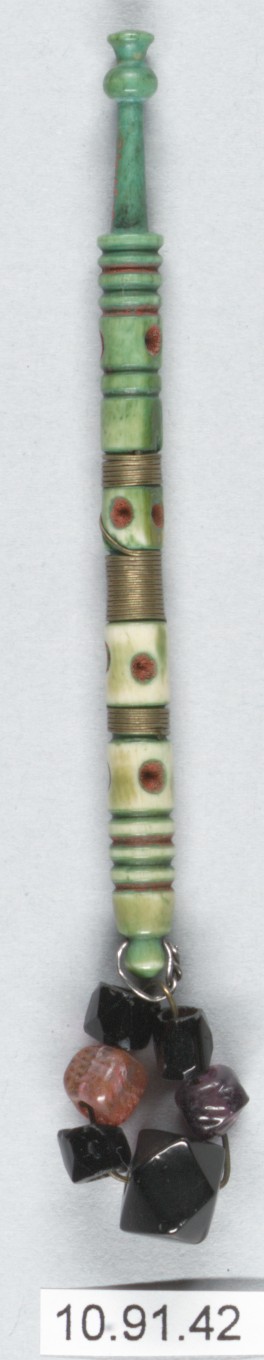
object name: bobbin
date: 1801-1900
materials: bone, metal